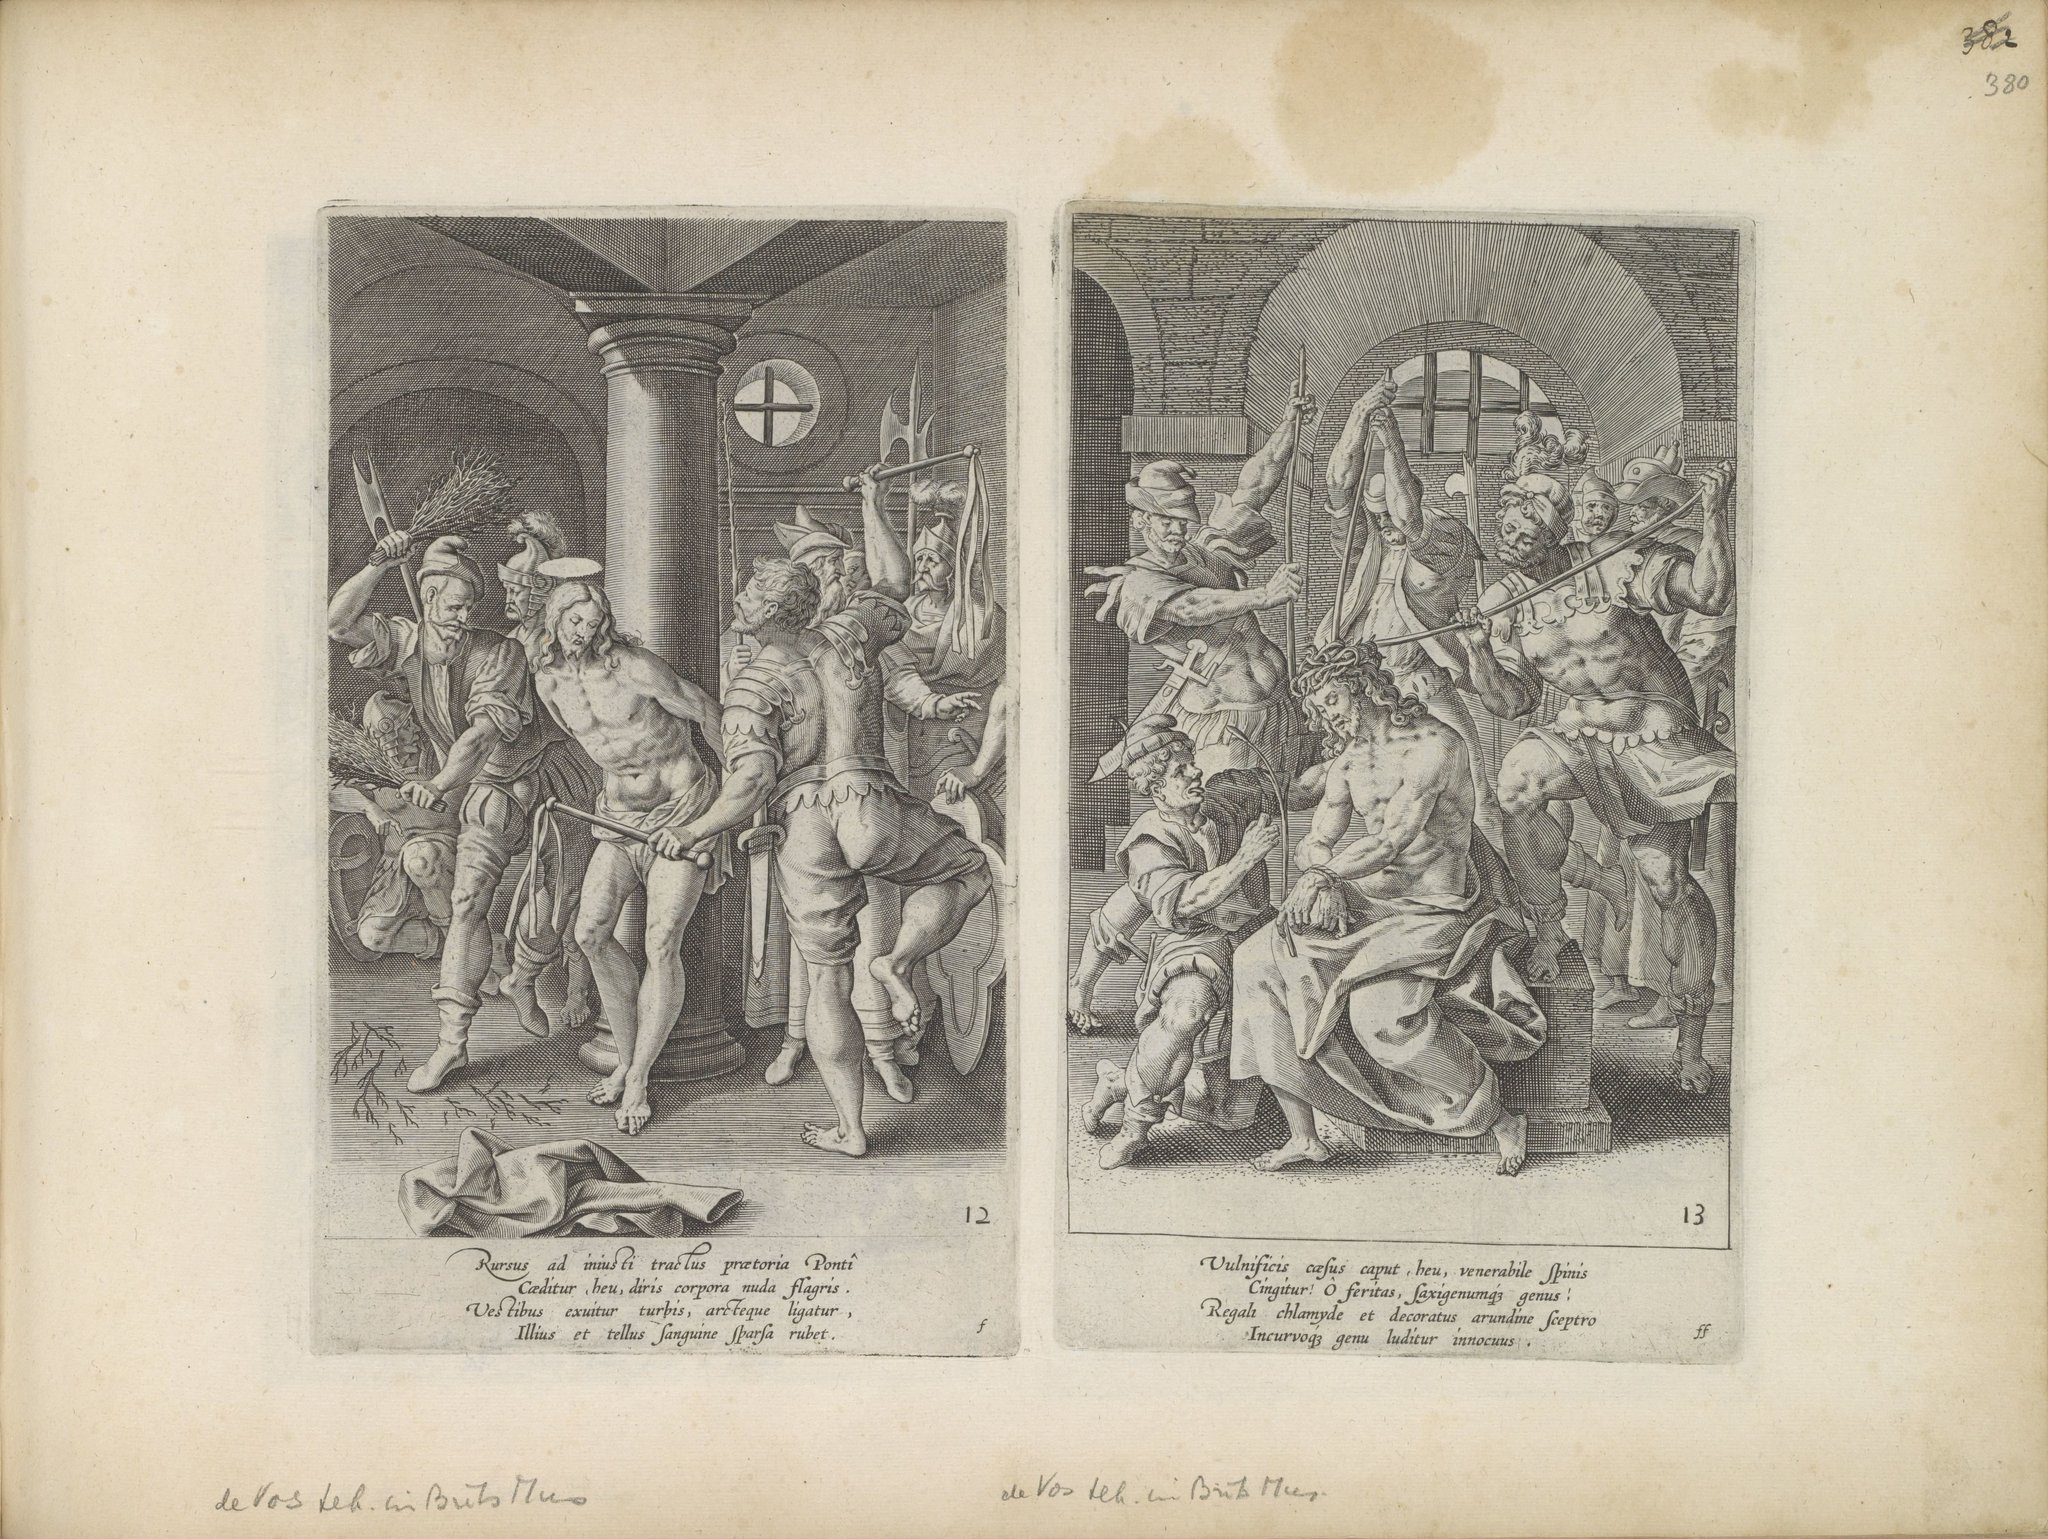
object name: print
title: Theatrum Biblicum Hoc Est Historiae Sacrae Veteris et Novi Testamenti Tabulis Aeneis Expressae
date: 1585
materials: paper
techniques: engraving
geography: amsterdam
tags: the crowning with thorns: soldiers with sticks place a thorny crown on christ's head and give him a reed (matthew 27:27-31; mark 15:16-20; john 19:2-3)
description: Soldaten duwen met stokken de doornenkroon op het hoofd van de met touwen geboeide Christus. Een man zit in geknielde houding voor Christus en bespot hem. Onder de voorstelling een vierregelig vers in het Latijn. Rechtsonder de letters: ff. Deze prent maakt deel uit van een album.